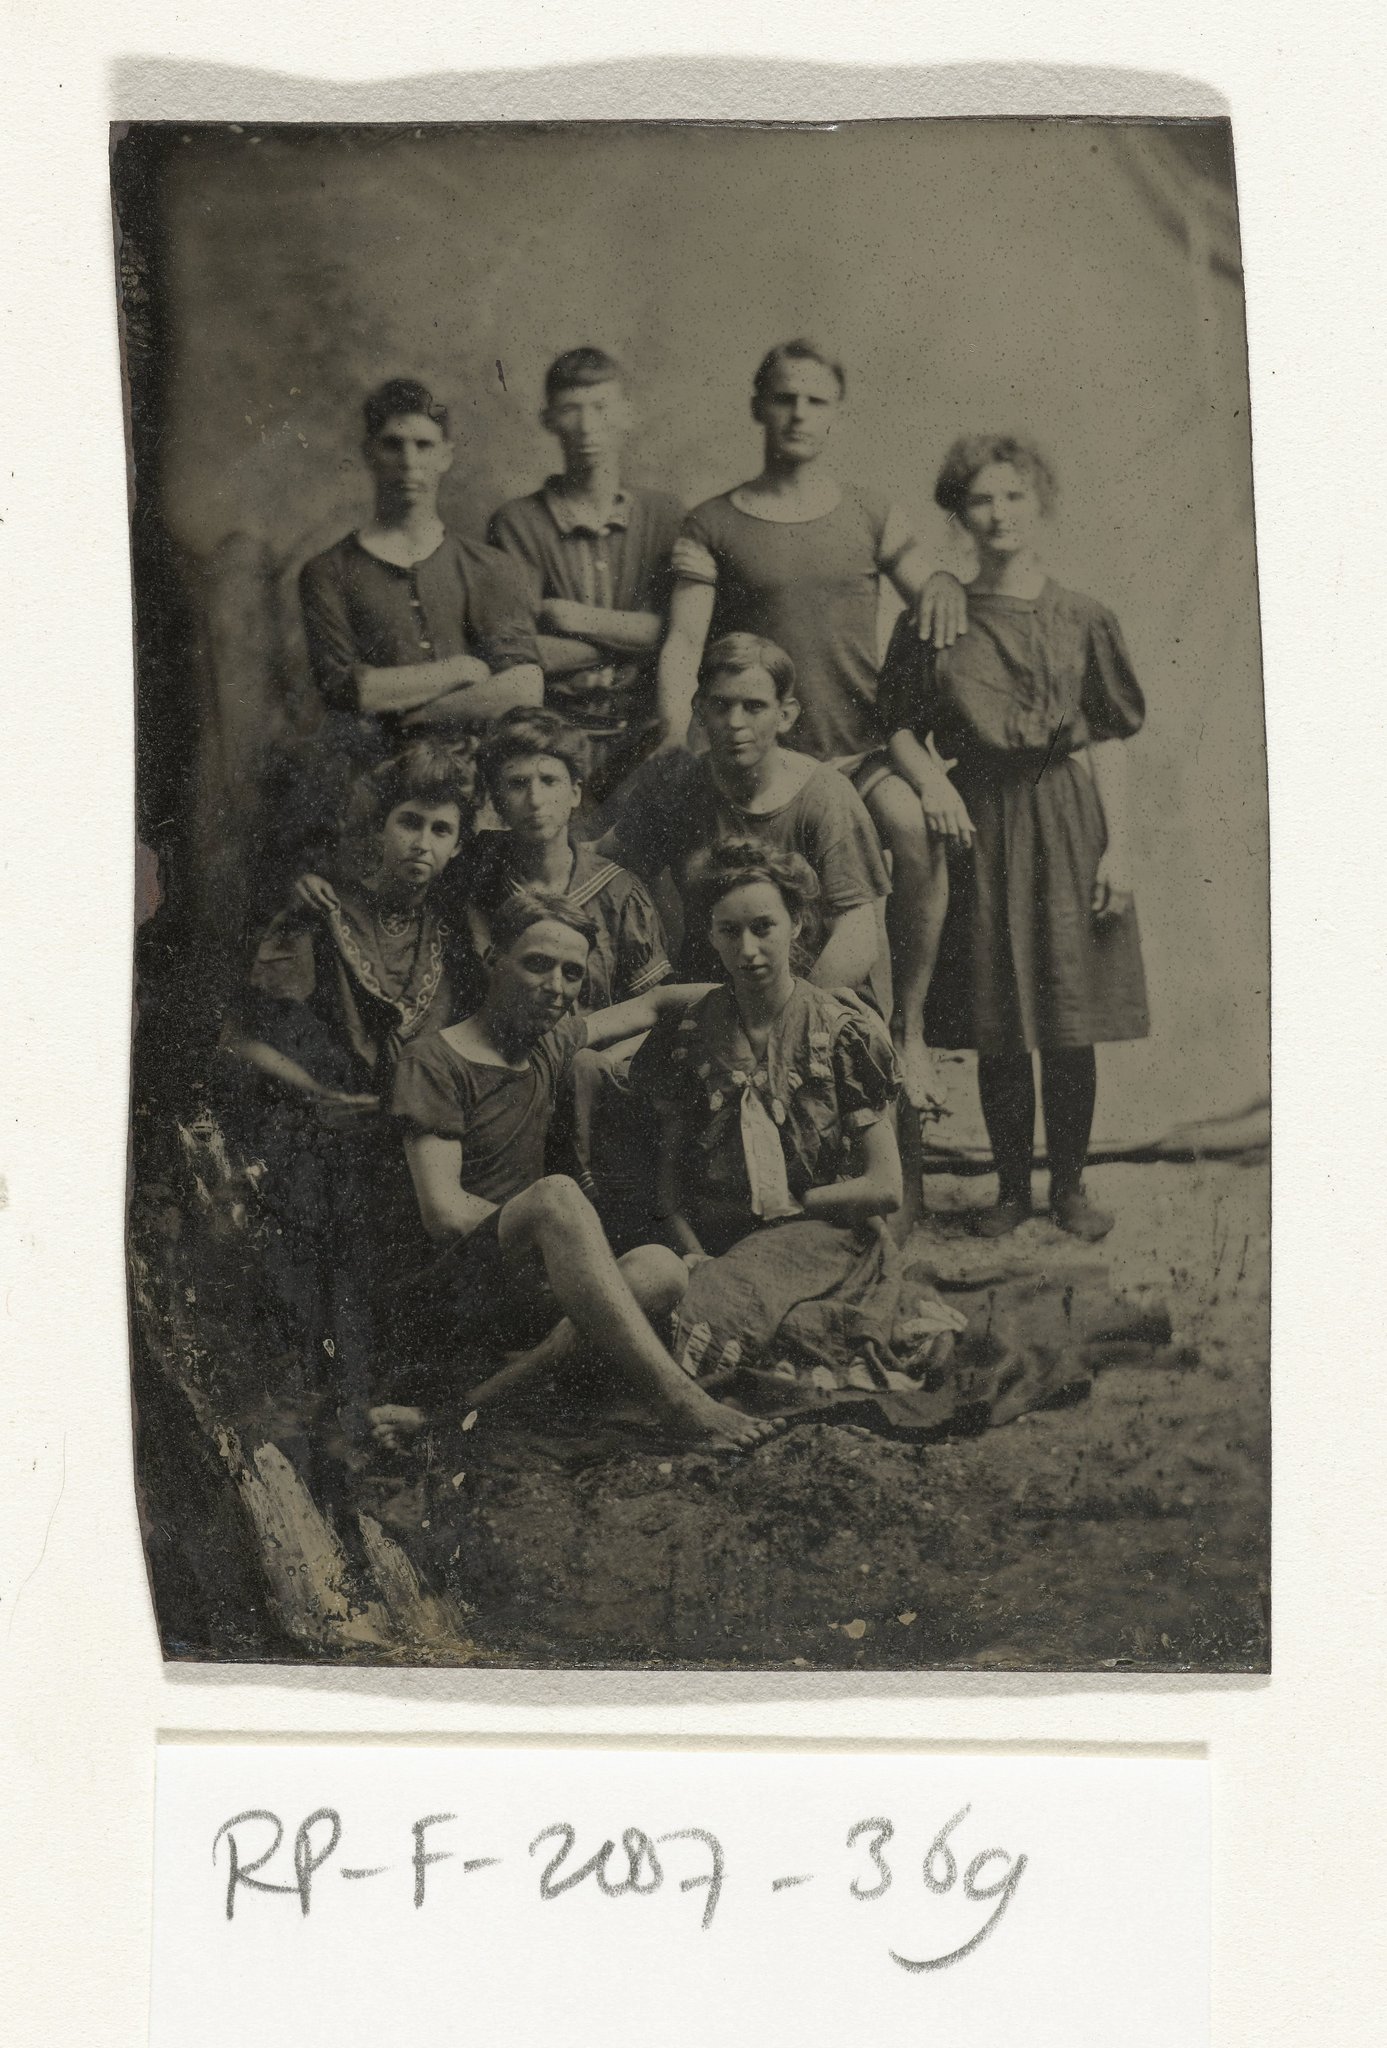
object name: photograph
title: Groepsportret van vijf mannen en vijf vrouwen (ten dele) in badkleding, staand en zittend in een studiodecor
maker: Anonymous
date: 1880-1910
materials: metal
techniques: ferrotyping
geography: united states